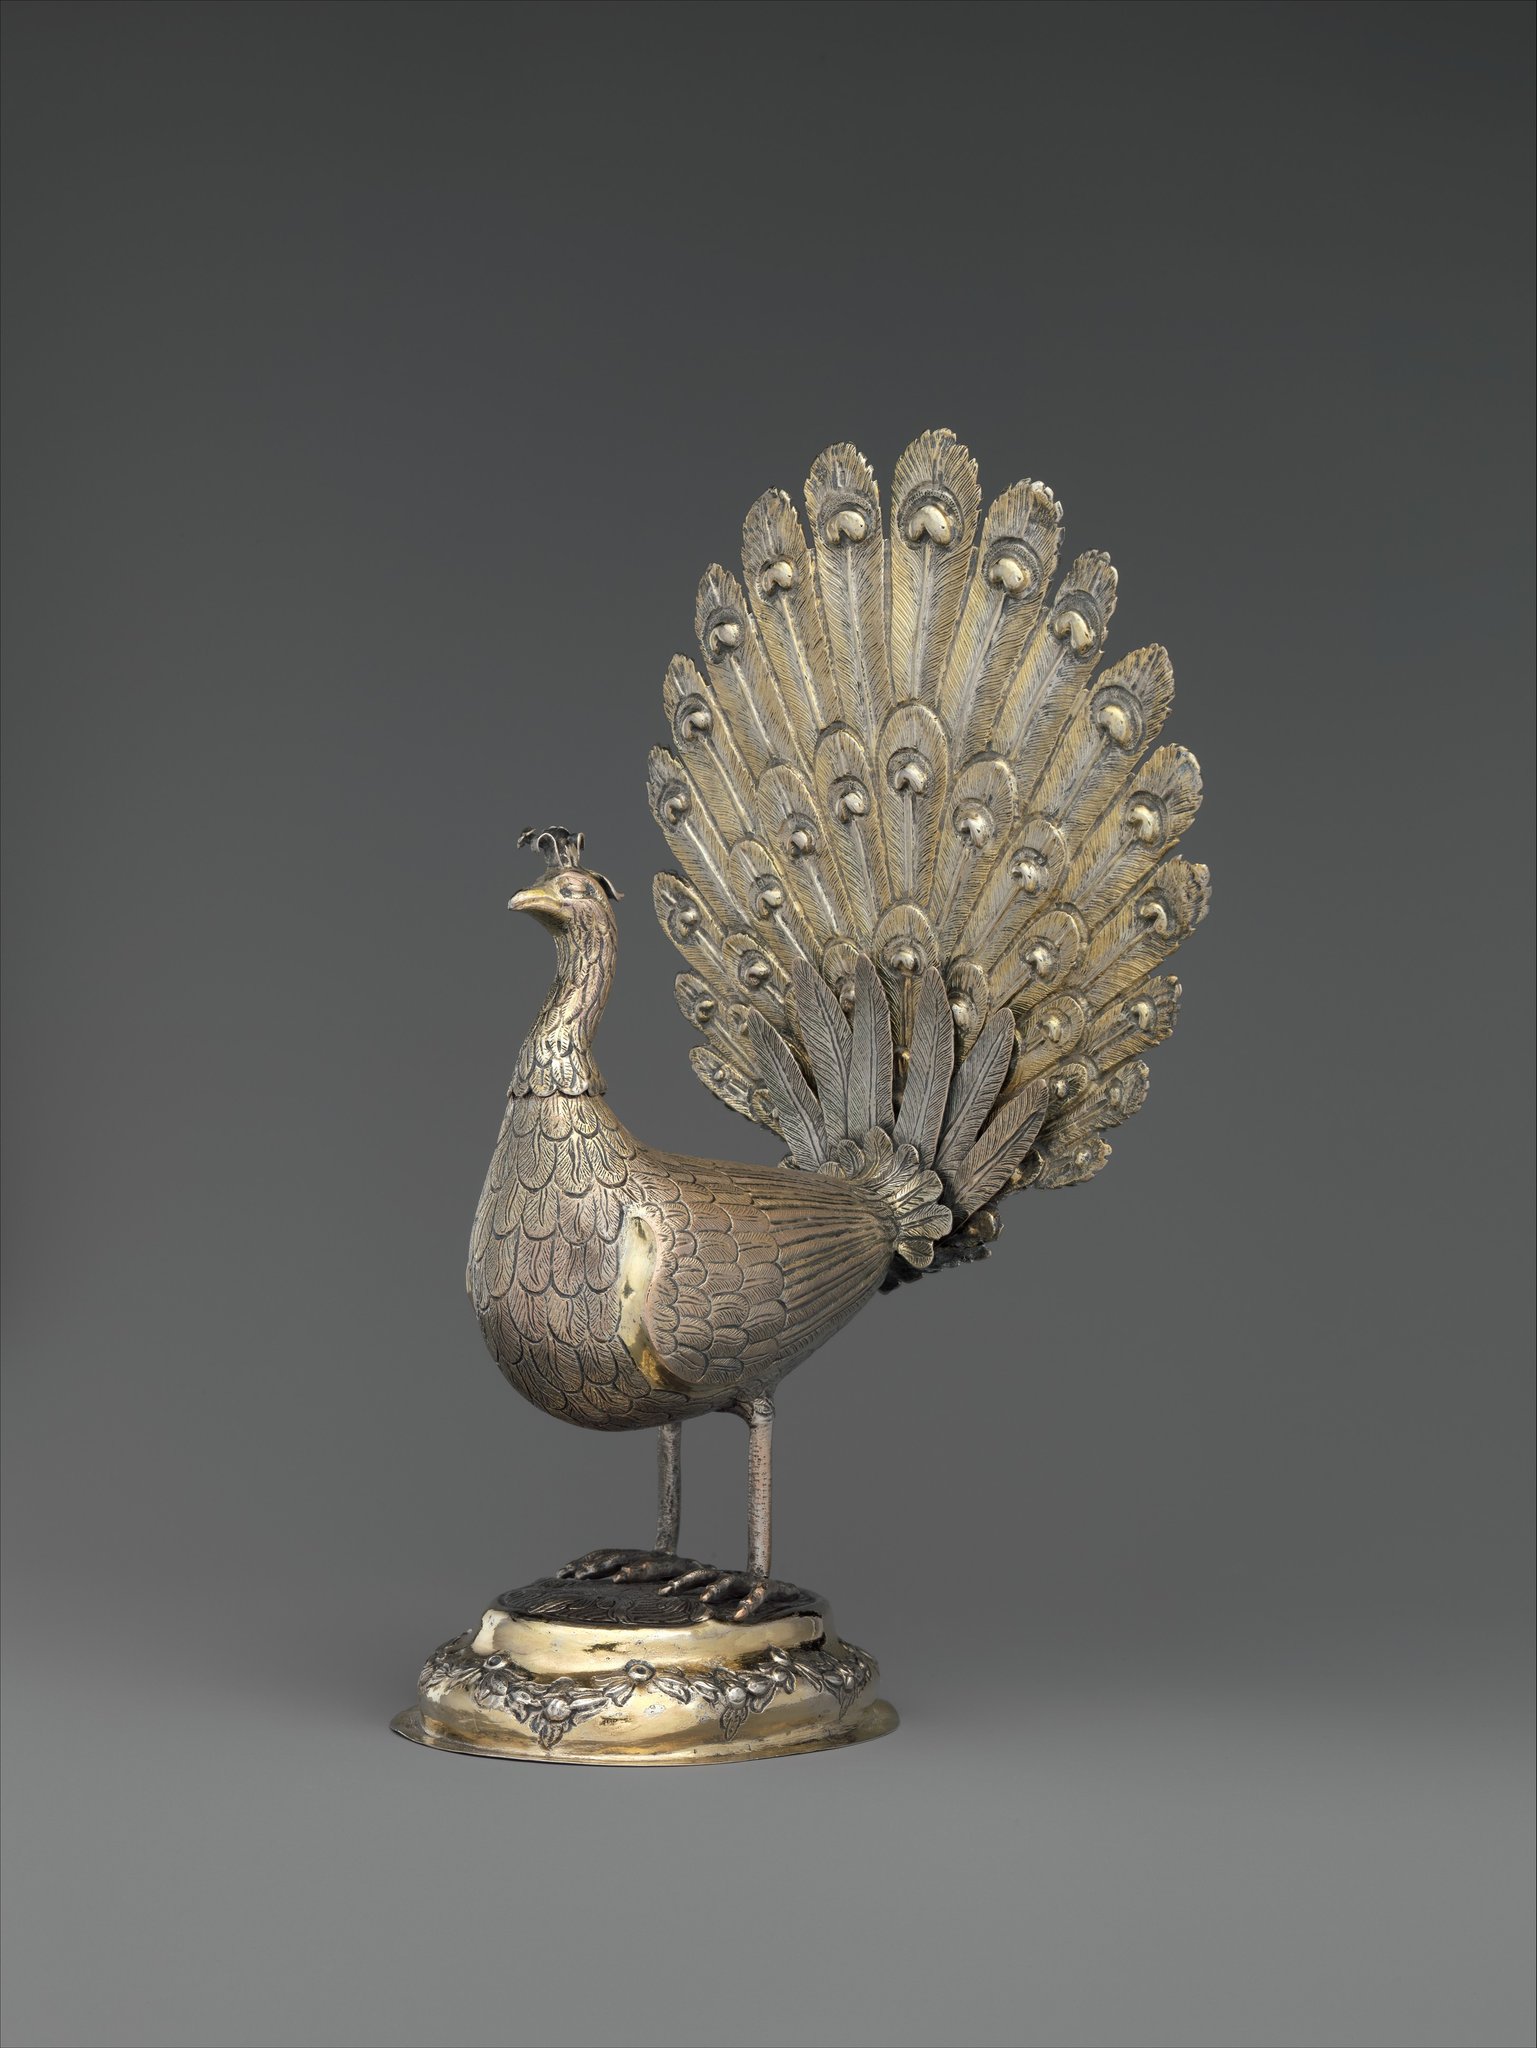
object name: figure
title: Table decoration in the form of a peacock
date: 1787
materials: silver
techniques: gilding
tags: peacocks